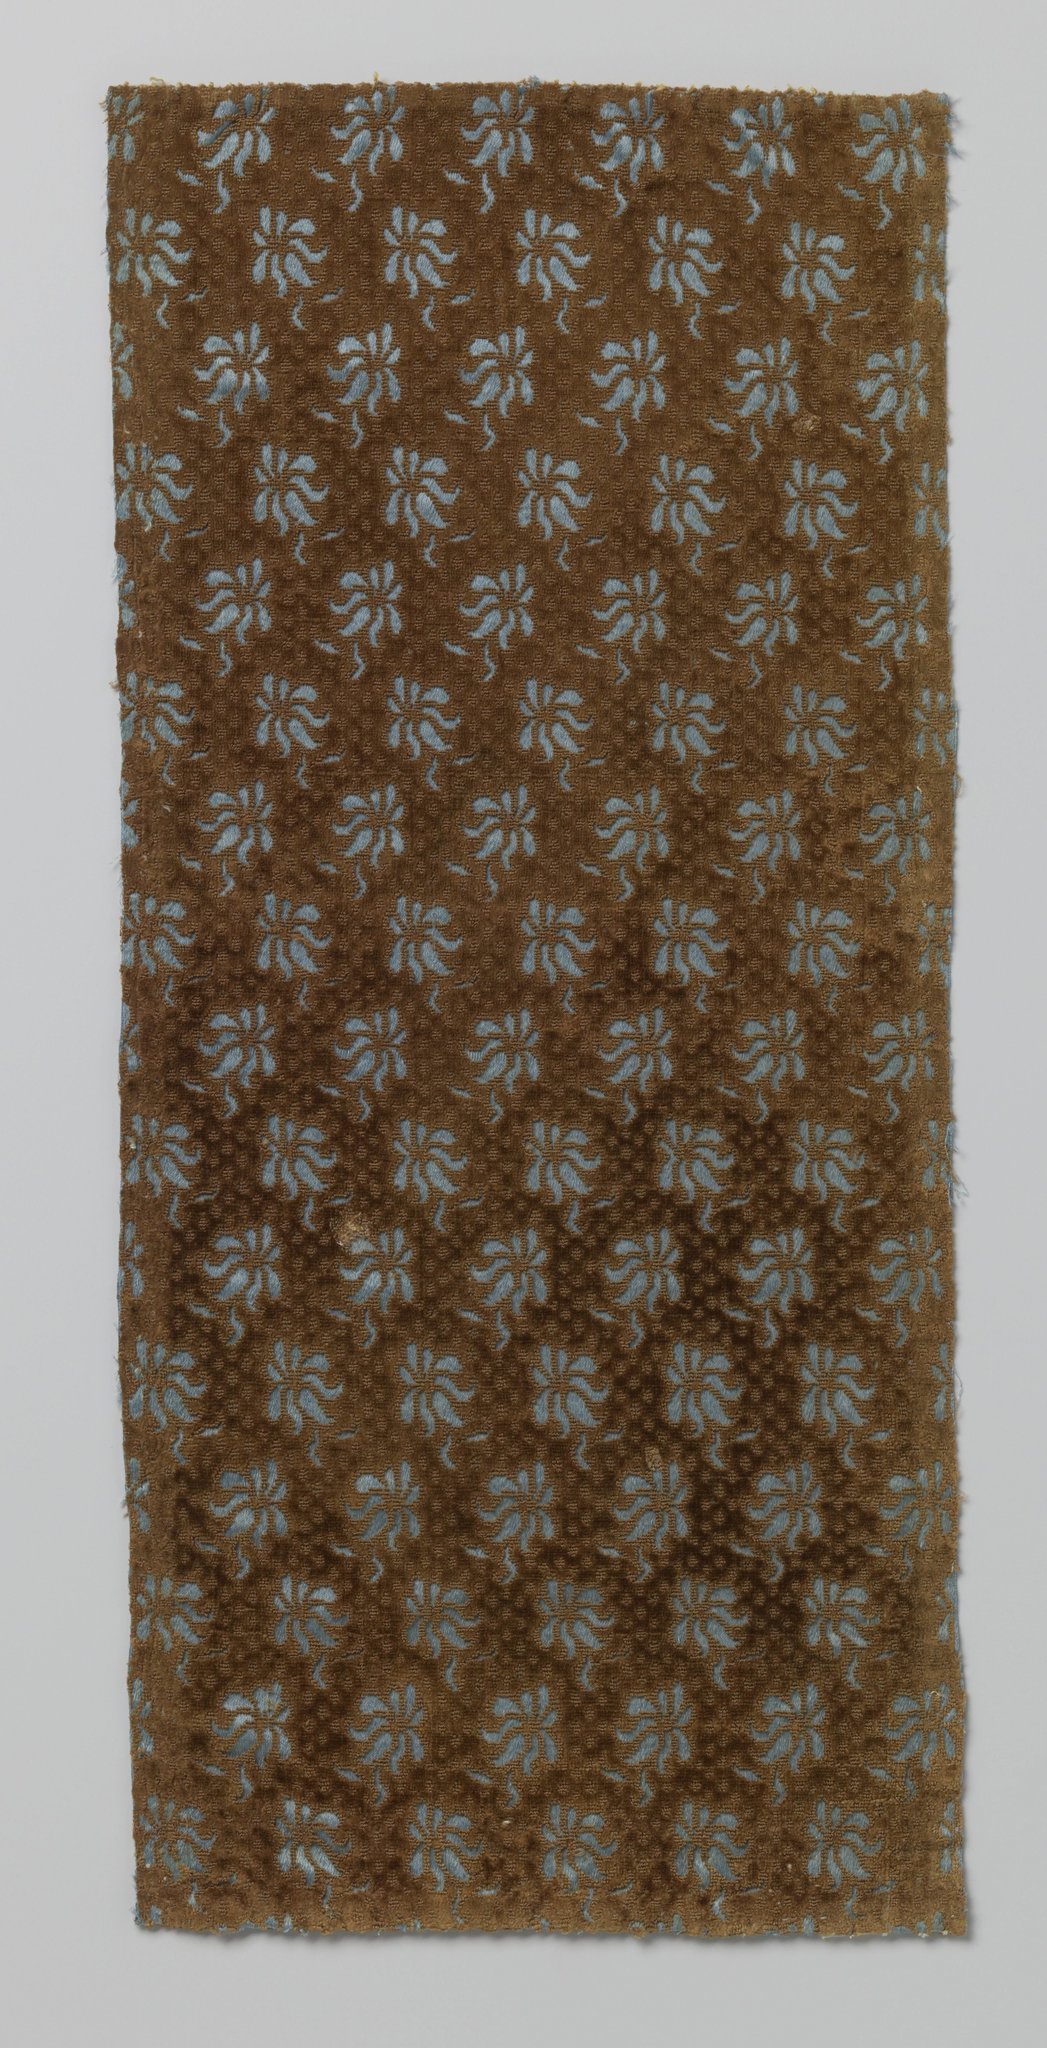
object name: zijdefluweel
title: Fragment polychroom zijdefluweel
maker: Anonymous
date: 1500-1599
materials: ciselé velvet, textile, silk, velvet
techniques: weave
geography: italy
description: Een fragment van polychroom zijdefluweel. Op een grond van hemelsblauw schering satijn zijn uit het bruin fluweel horizontaal gerij de achtbladige bloemkelken en discreet aangebrachte slangen lijntjes gespaard.